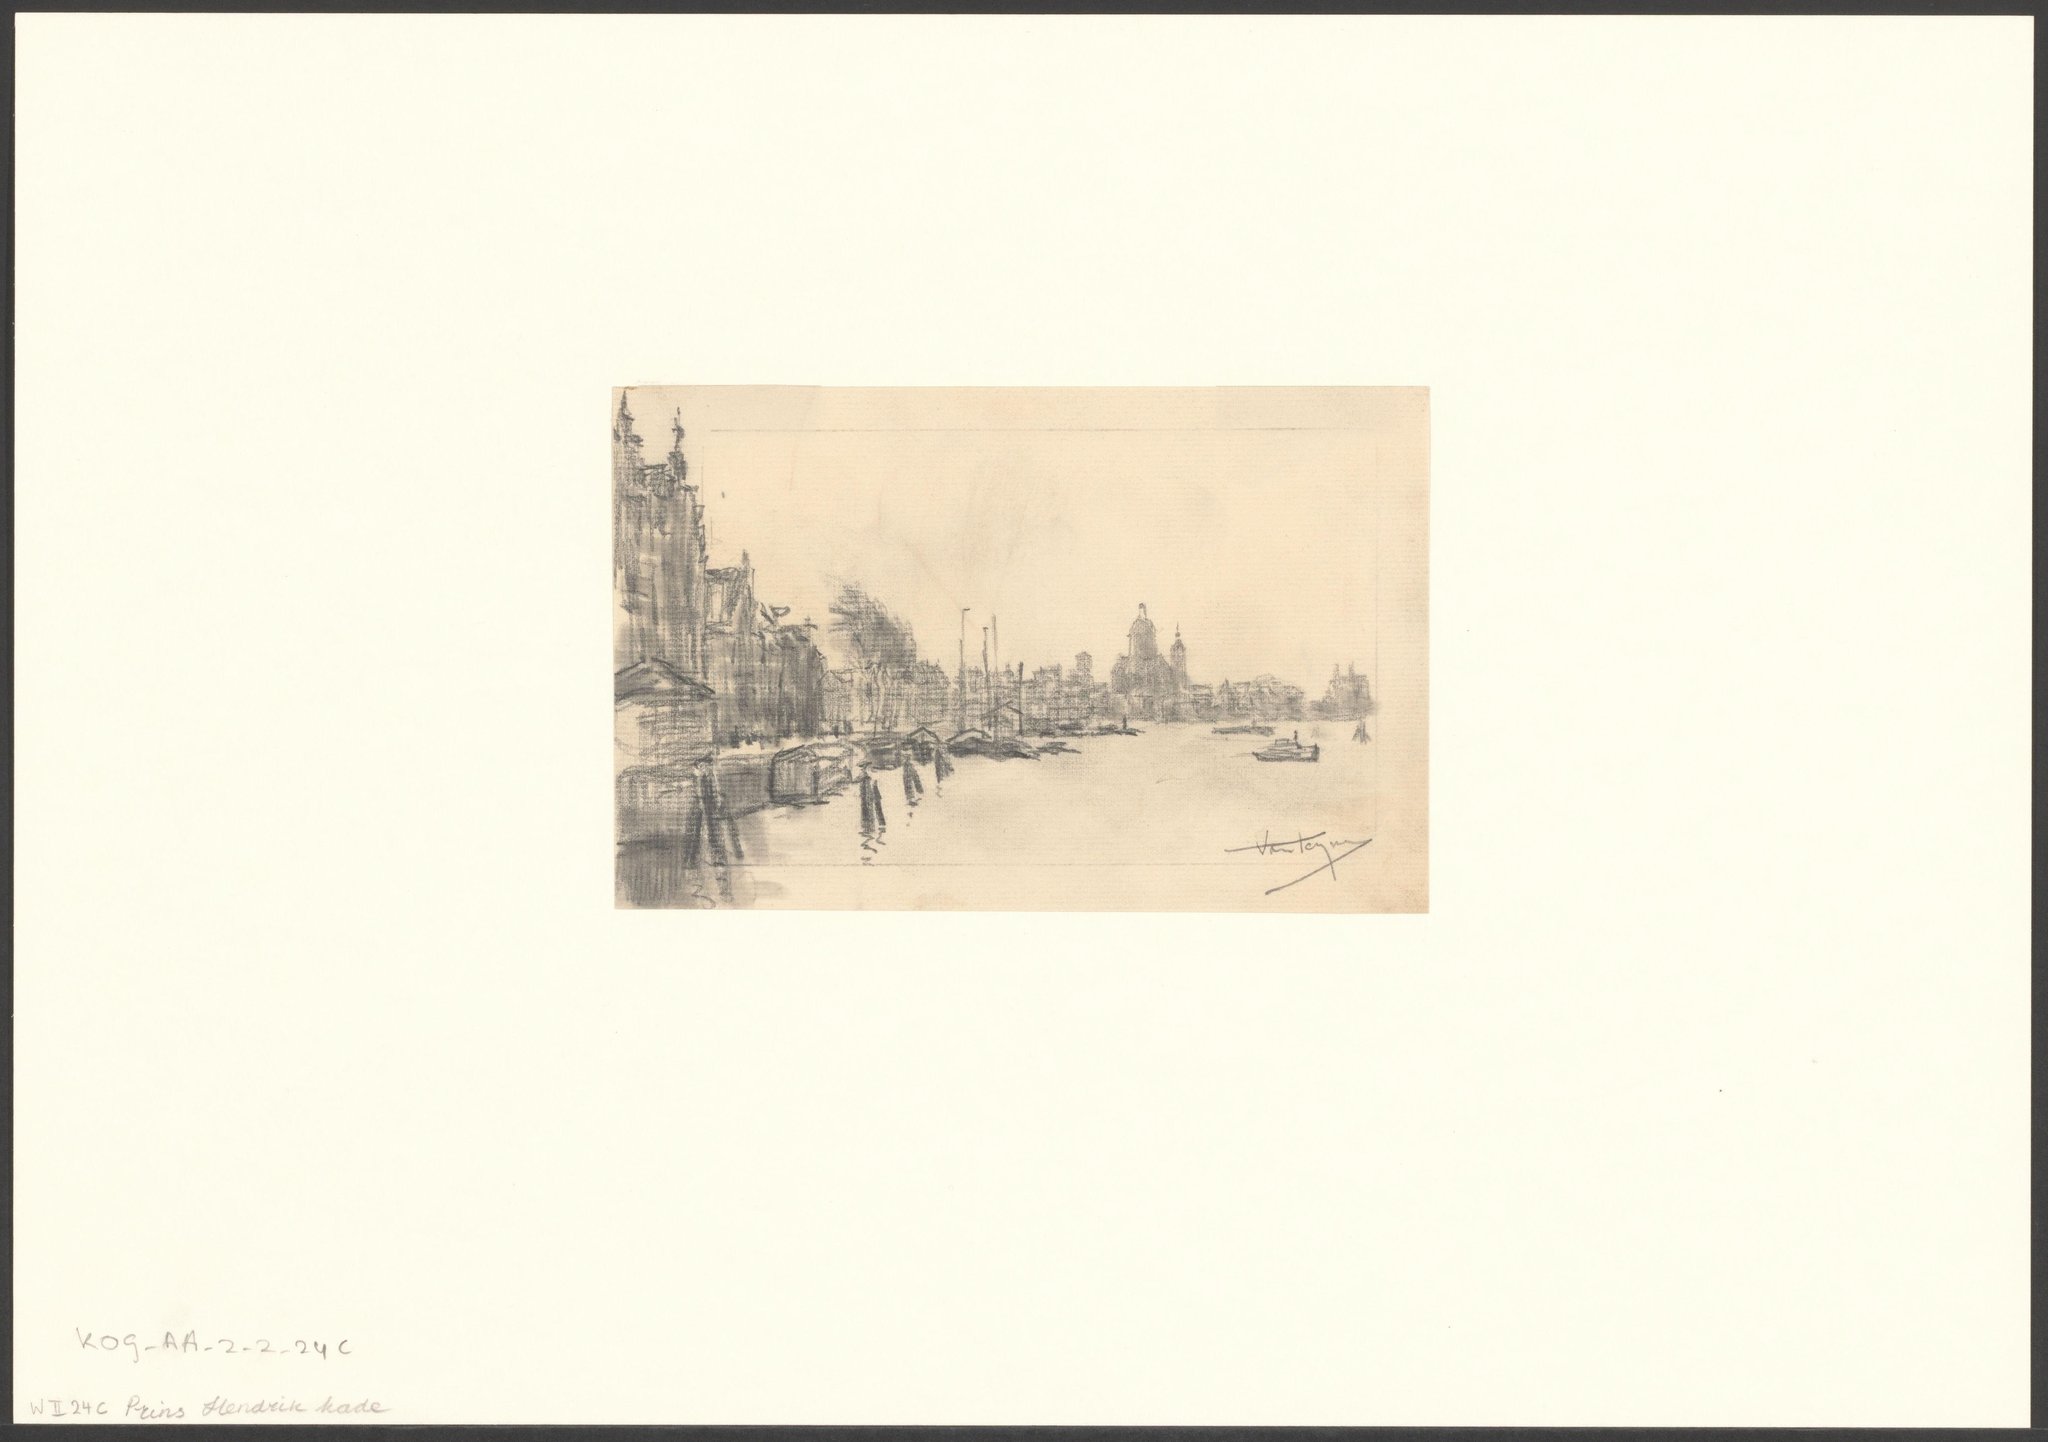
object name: drawing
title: Gezicht op de Prins Hendrikkade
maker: anthonie van teijn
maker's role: draughtsman, painter, print maker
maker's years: 1863-1943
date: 1873-1943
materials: chalk, paper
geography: amsterdam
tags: city-view in general; 'veduta', river, quay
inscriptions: signature: ‘van teyne’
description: Tekening binnen de Atlas Van Eck ingedeeld op wijknummer 2.